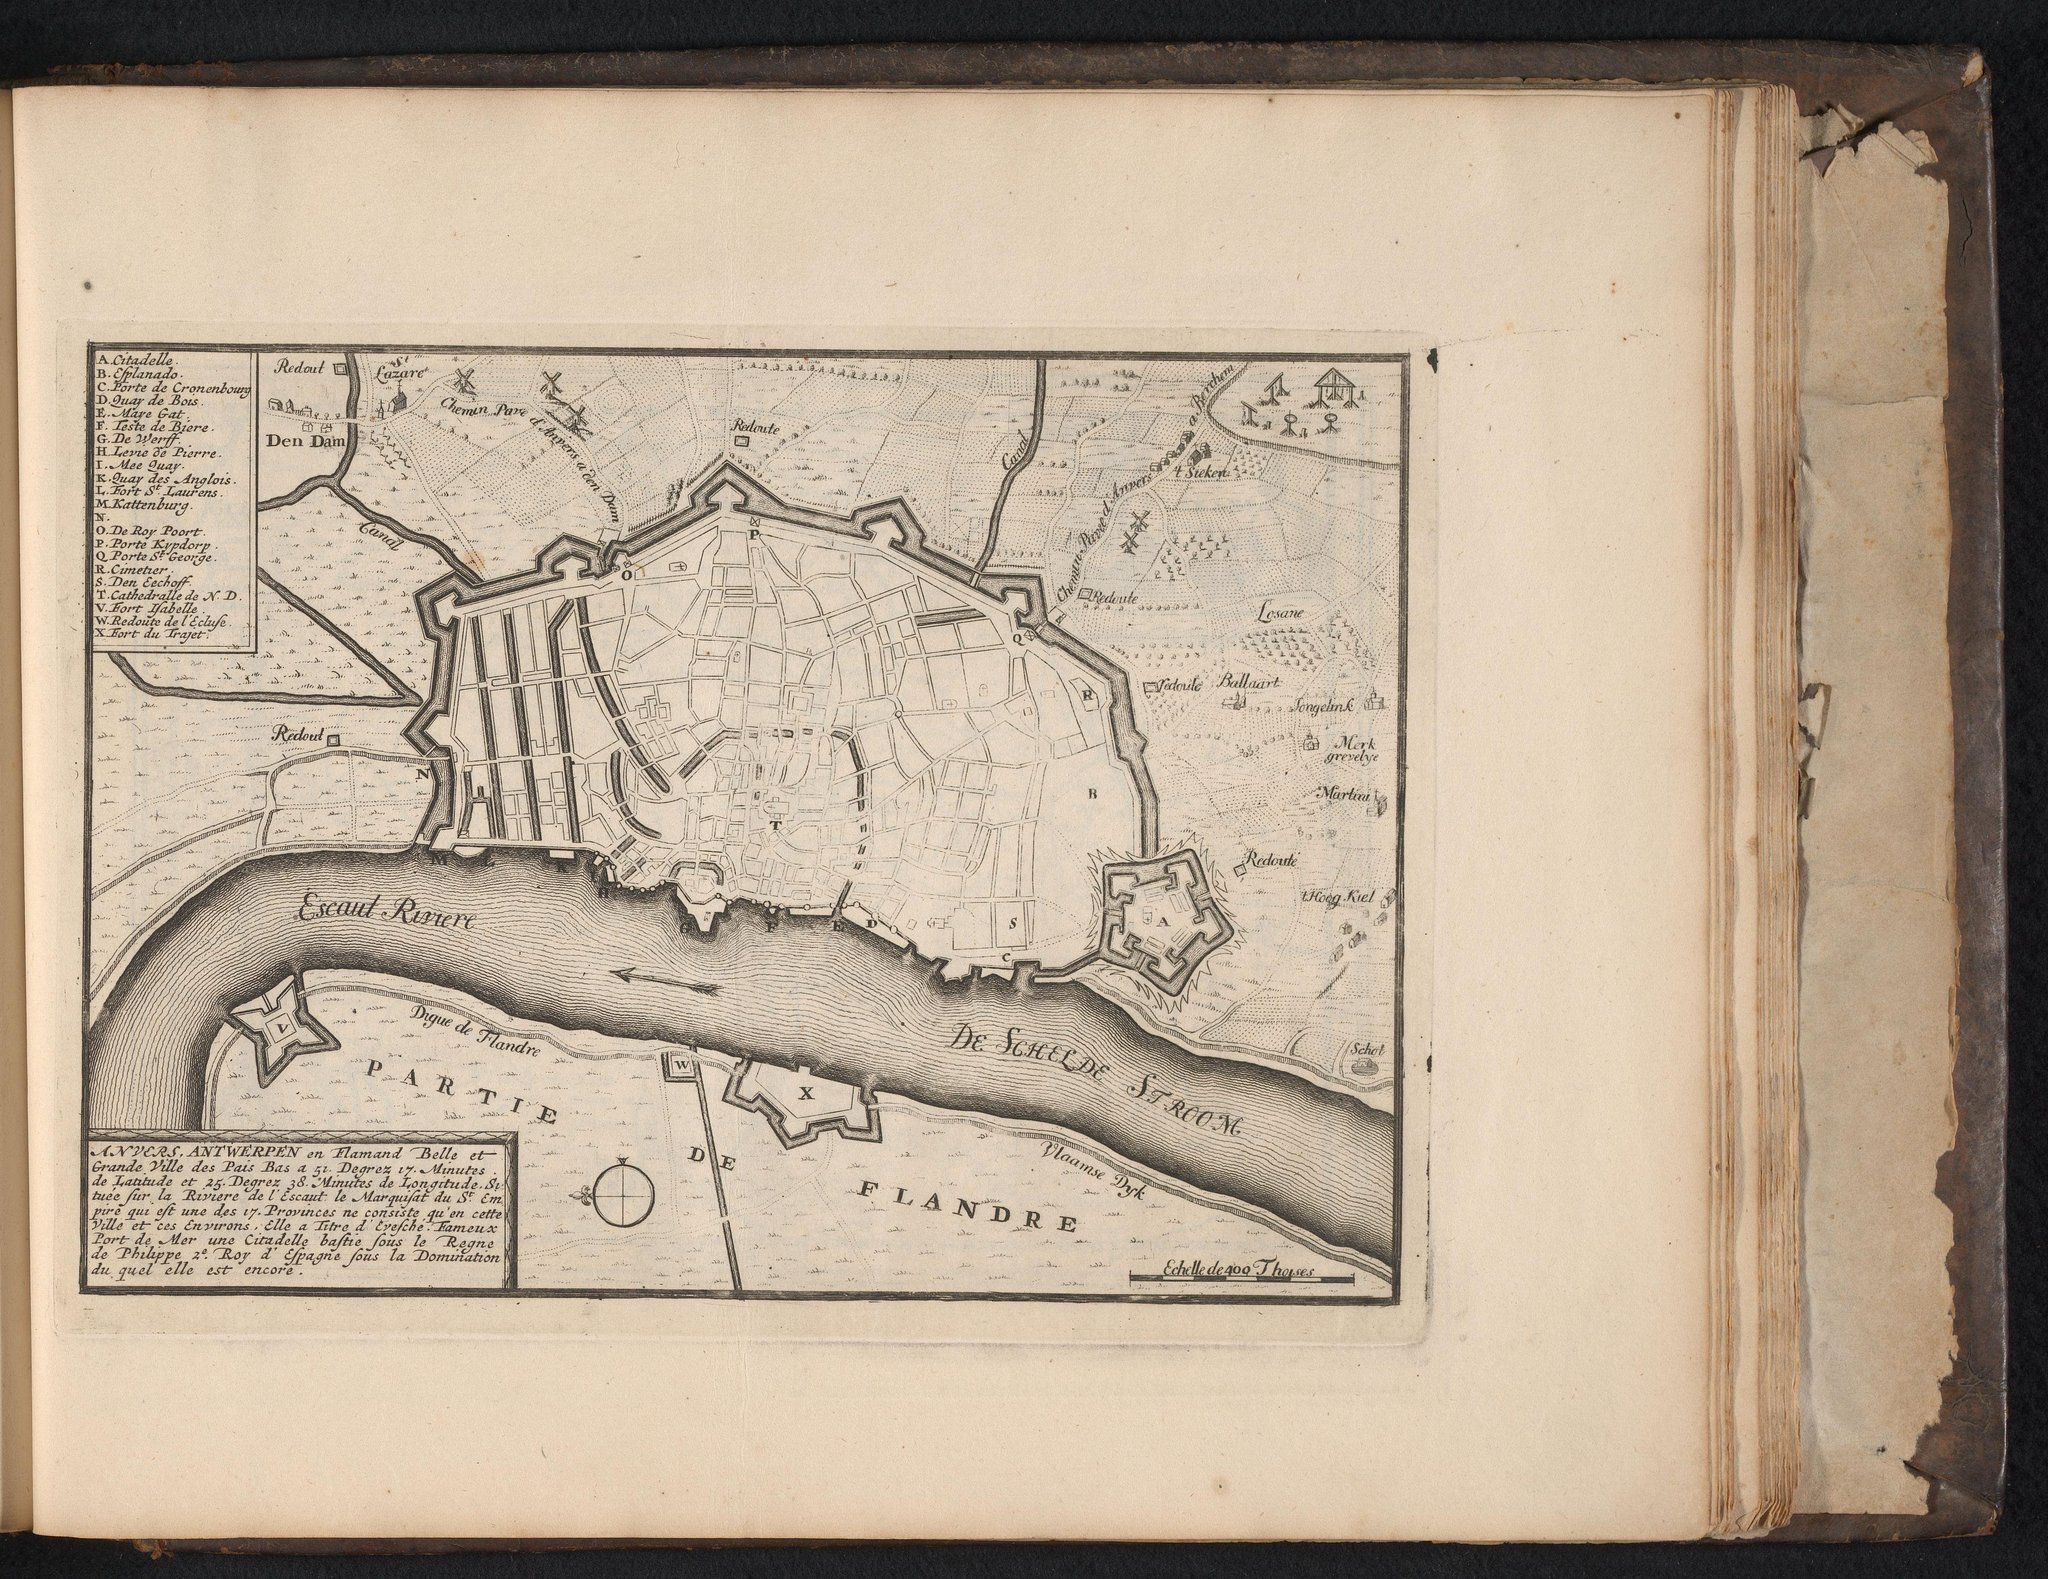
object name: print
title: Plattegrond van Antwerpen, ca. 1693-1696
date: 1693-1696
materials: paper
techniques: etching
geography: france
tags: maps of cities, antwerp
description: Plattegrond van Antwerpen. Onderdeel van het tweede van twee delen van het prentwerk: Le Theatre de la Guerre, dans les Pays-Bas, waarvan het titelblad uitgegeven is in 1696. Het prentwerk bestaat in totaal (beide delen) uit 52 platen met plannen (afkomstig van Sébastien Le Prestre, Seigneur de Vauban) van vermaarde sterke steden en vestingen in de Negenjarige Oorlog in de Nederlanden. Variant (kopie?) van de plaat die voorkomt in: Les forces de l'Europe, uitgegeven tussen 1693-1697. Titel en opschriften in het Frans.